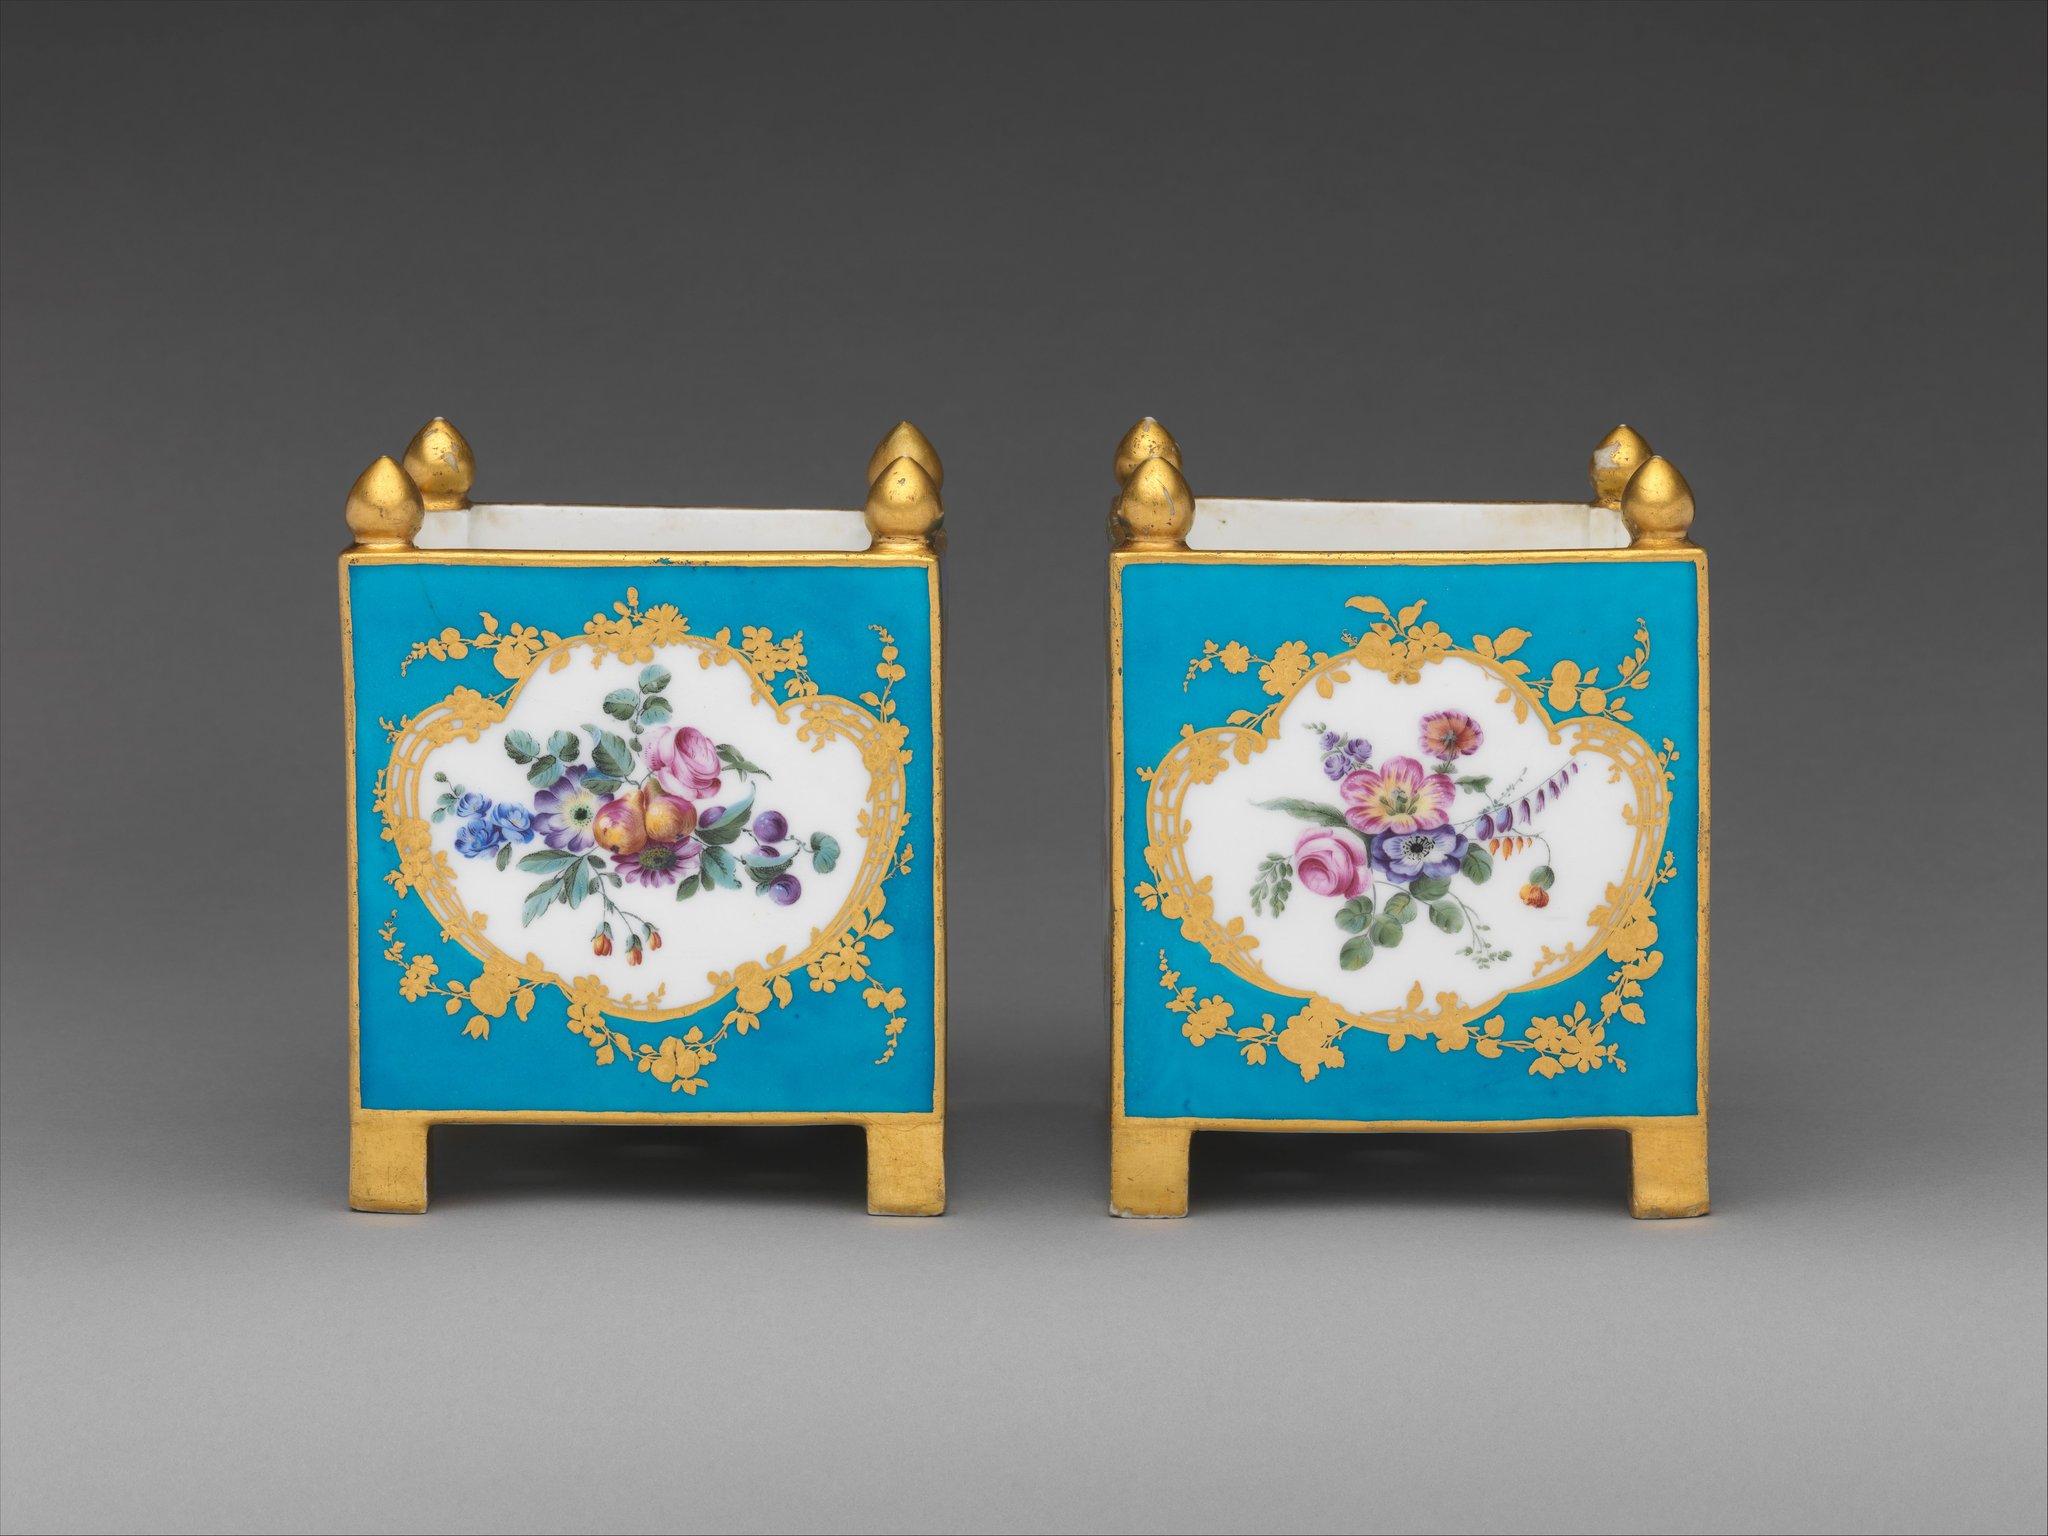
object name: orange tub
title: Pair of orange tubs (caisses carrées)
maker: vincennes manufactory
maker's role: manufactory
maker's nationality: french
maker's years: 1740-1756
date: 1754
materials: soft paste porcelain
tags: fruit,flowers